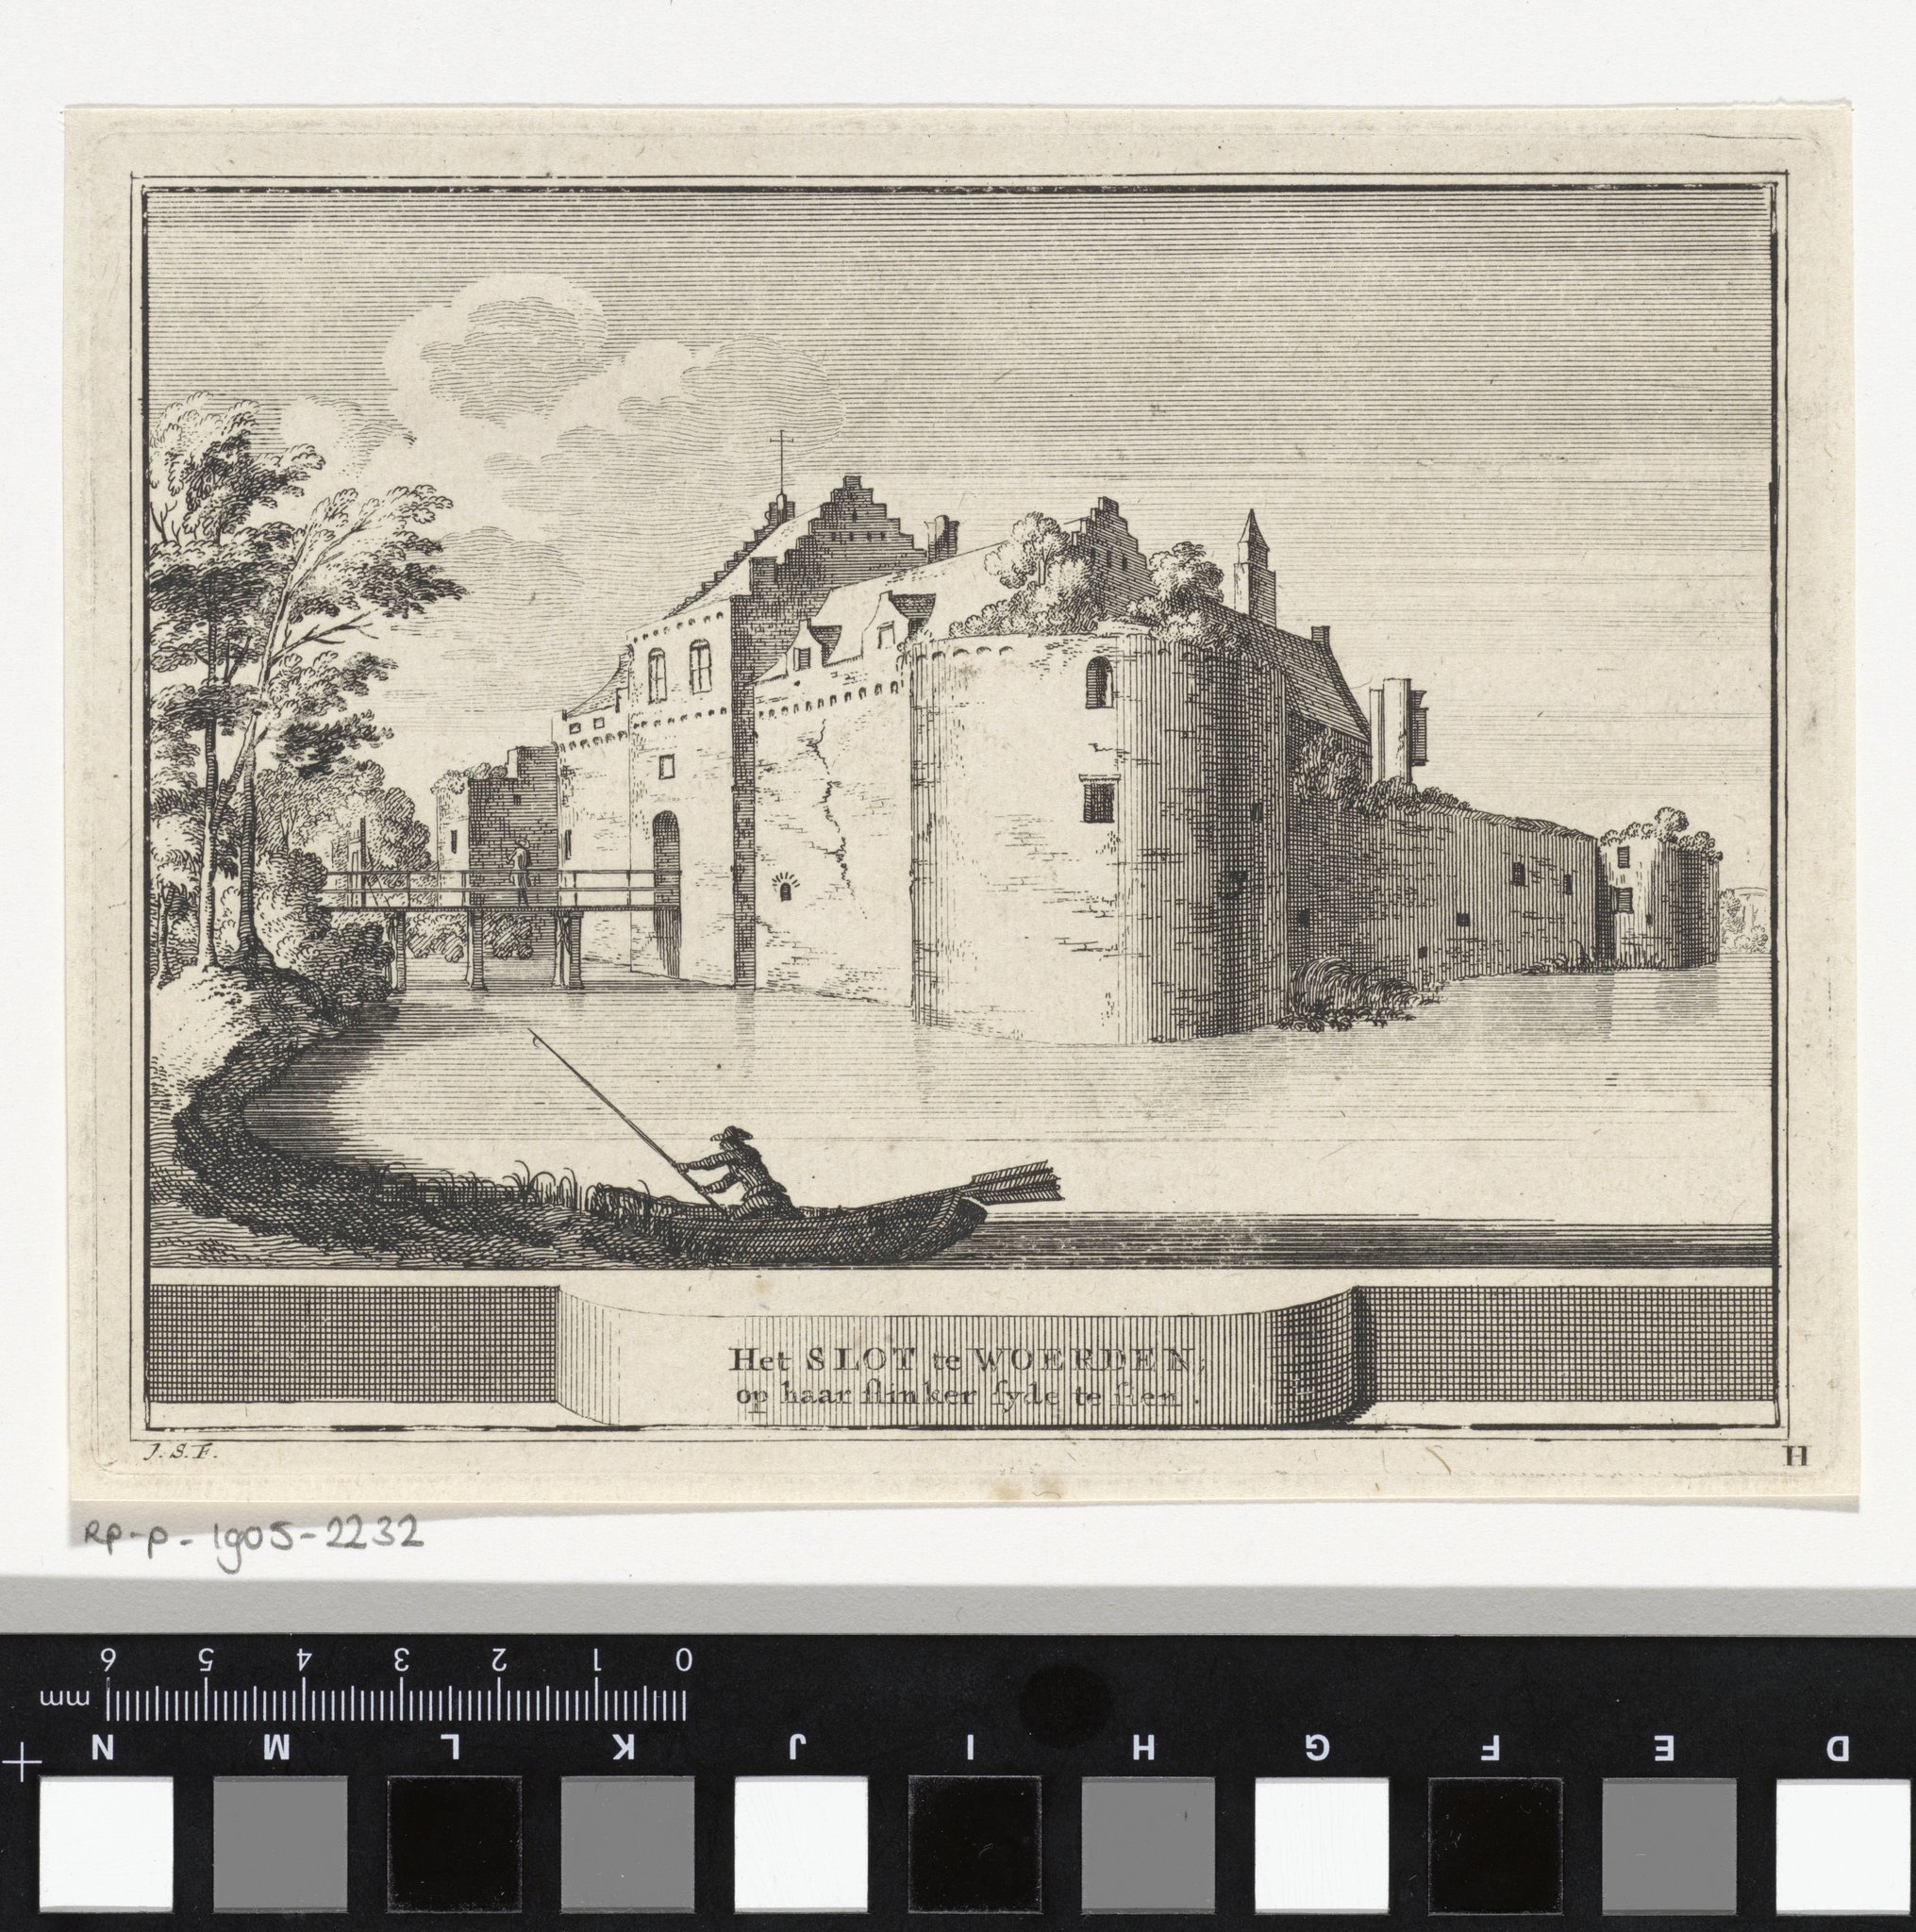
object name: print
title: Het Slot te Woerden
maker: jacobus schijnvoet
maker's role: draughtsman, print maker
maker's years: 1685-1743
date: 1711-1774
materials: paper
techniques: etching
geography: amsterdam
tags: castle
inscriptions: collector's mark: Lugt 2228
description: Prent als illustratie opgenomen in: Smids, Ludolph. Schatkamer der Nederlandsse[!] oudheden; of Woordenboek, behelsende Nederlands steden, Amsterdam: Pieter de Coup, 1711. Verscheen tevens in de heruitgave van voorgenoemd werk in 1737 en 1774. In 1721 verscheen er een uitgave met alleen de prenten: Nederlandsche oudheden, bestaande in zestig verbeeldingen (...) gelegen in Holland, 't Sticht van Utrecht en Gelderland enz. Amsterdam: Hendrik Bosch, 1721.